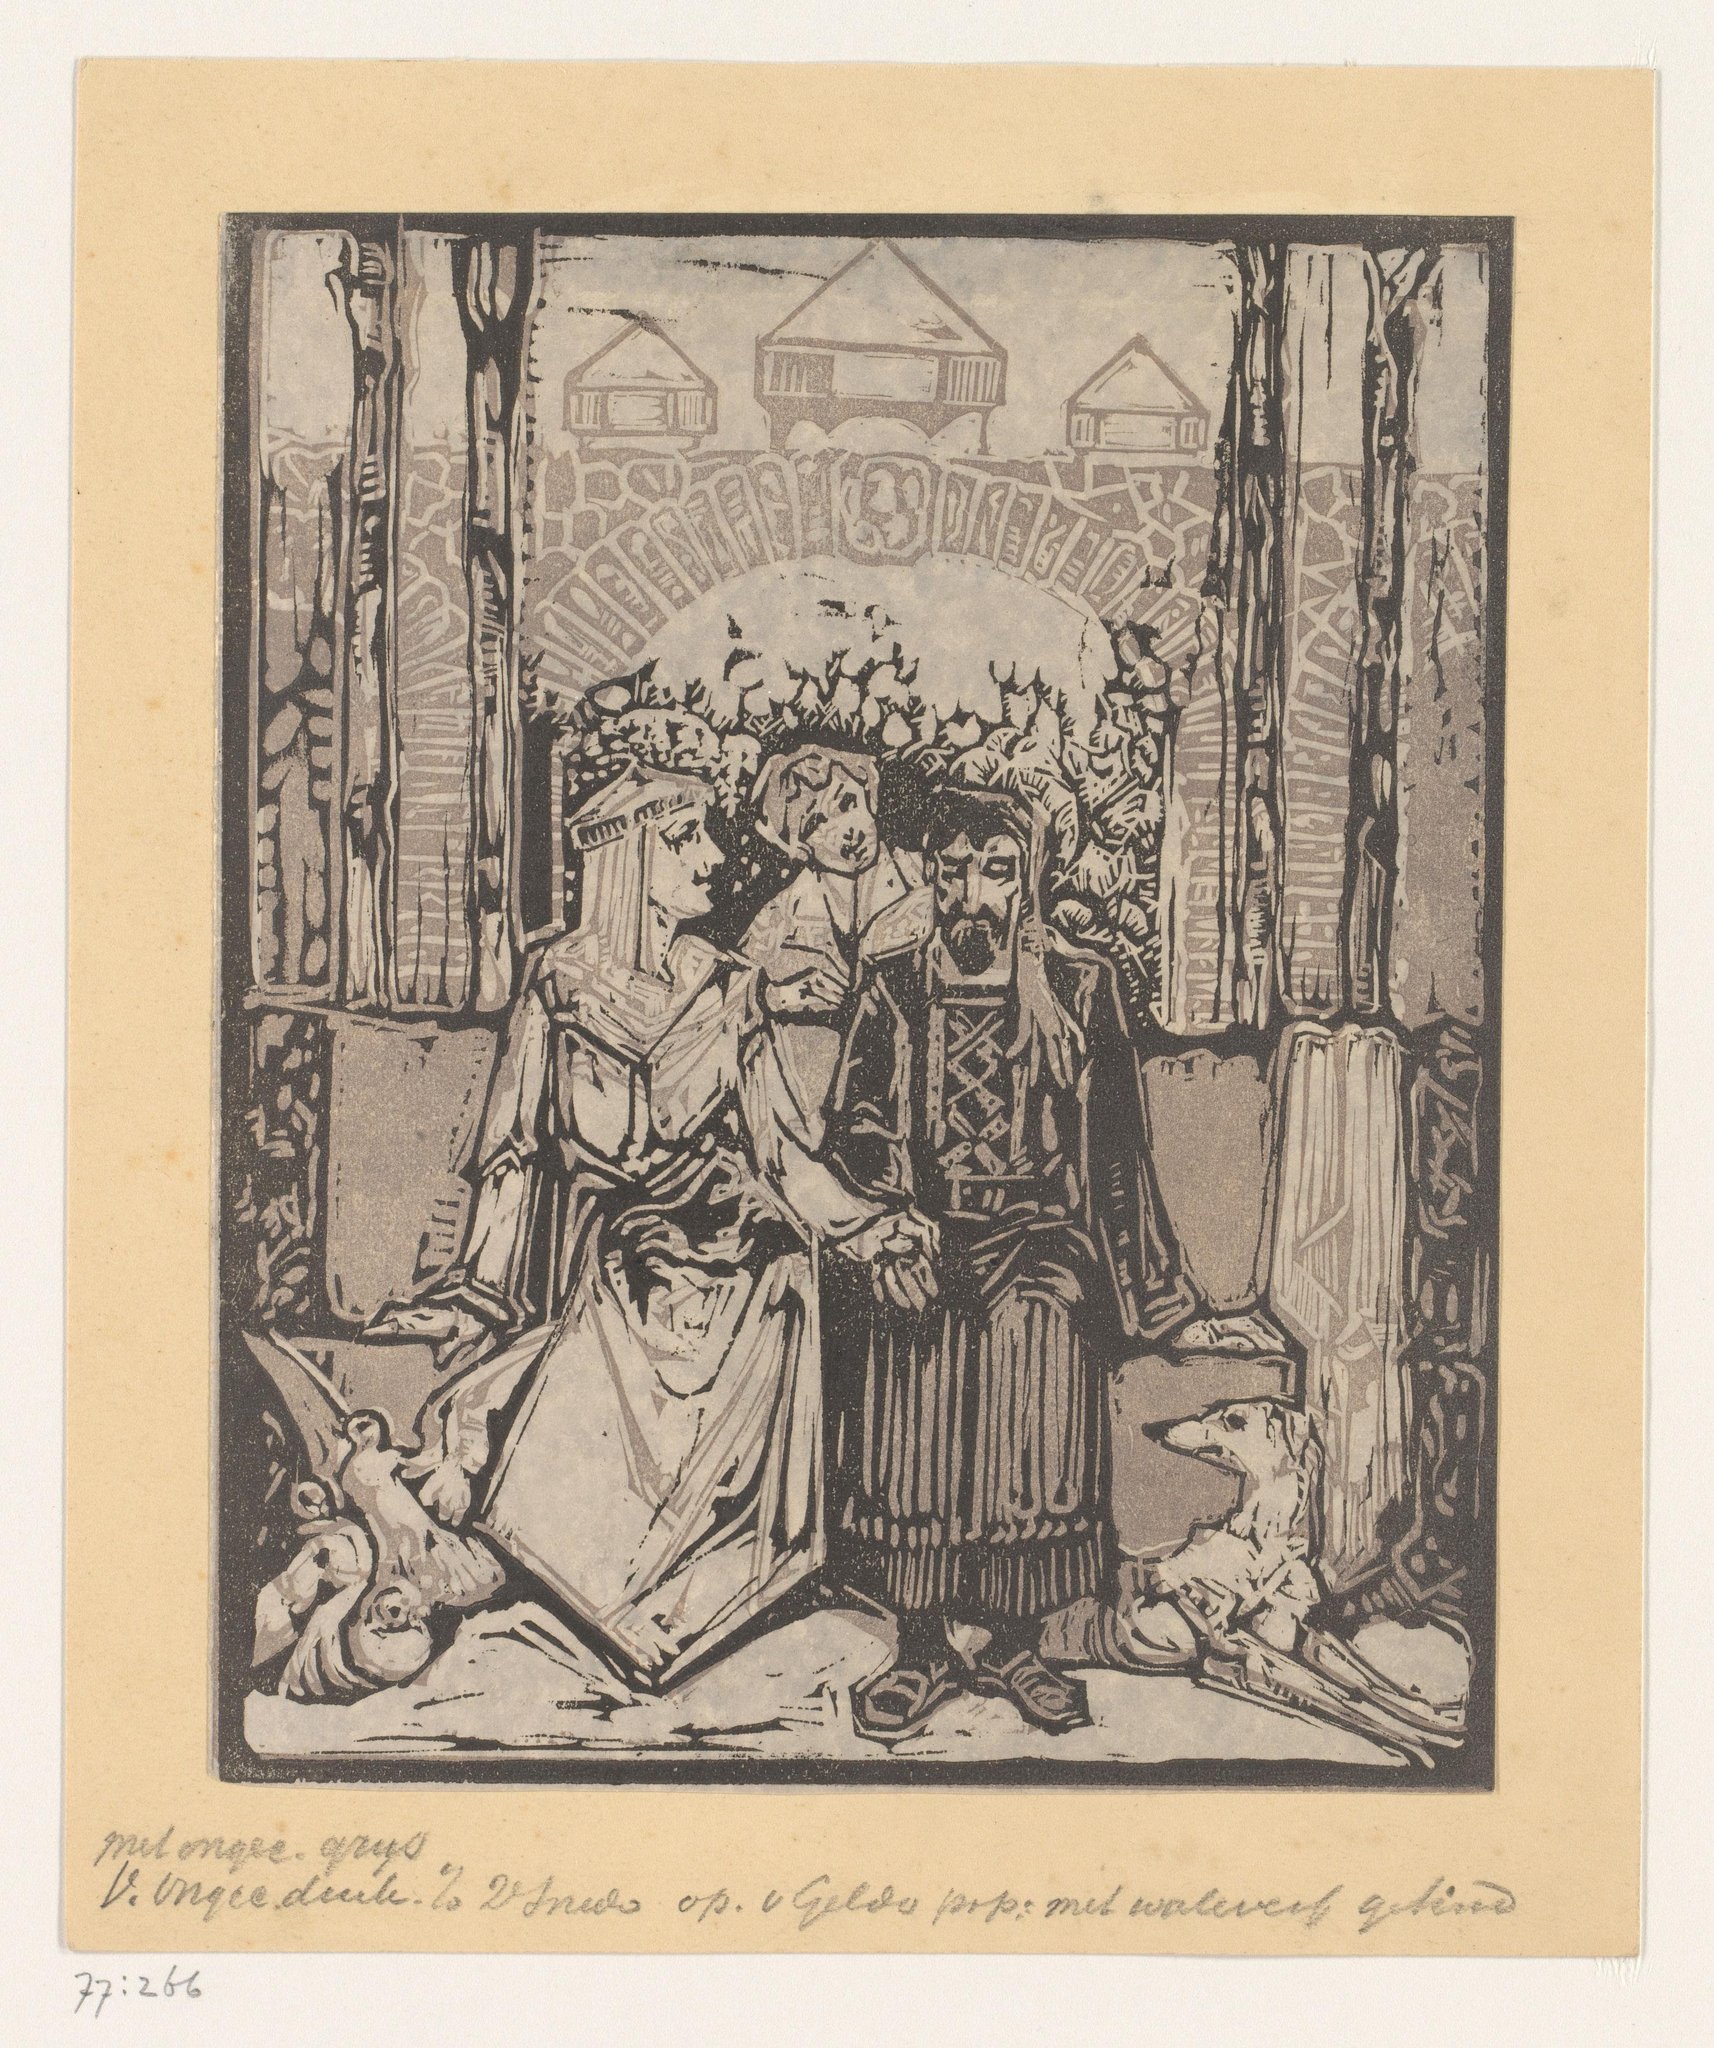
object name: print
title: Zittend paar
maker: bernard willem wierink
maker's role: draughtsman, print maker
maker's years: 1856-1939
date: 1910-1937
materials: paper, watercolor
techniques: hand coloring, relief print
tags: other birds: dove, couple of lovers, dog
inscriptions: collector's mark, annotation: ‘Met ongec. grijs/ 1e ongec. druk v/d 2e snede op v. Gelder pap met waterverf getint’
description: Illustratie voor een uitgave van een onbekend toneelstuk. Deze prent is waarschijnlijk een plaatsnede, ook al wordt in de literatuur veelal gesproken over een houtsnede. Voor zover Wierink zijn prenten in hoogdruk zelf heeft omschreven, heeft hij altijd de term 'plaatsnede' gebruikt.